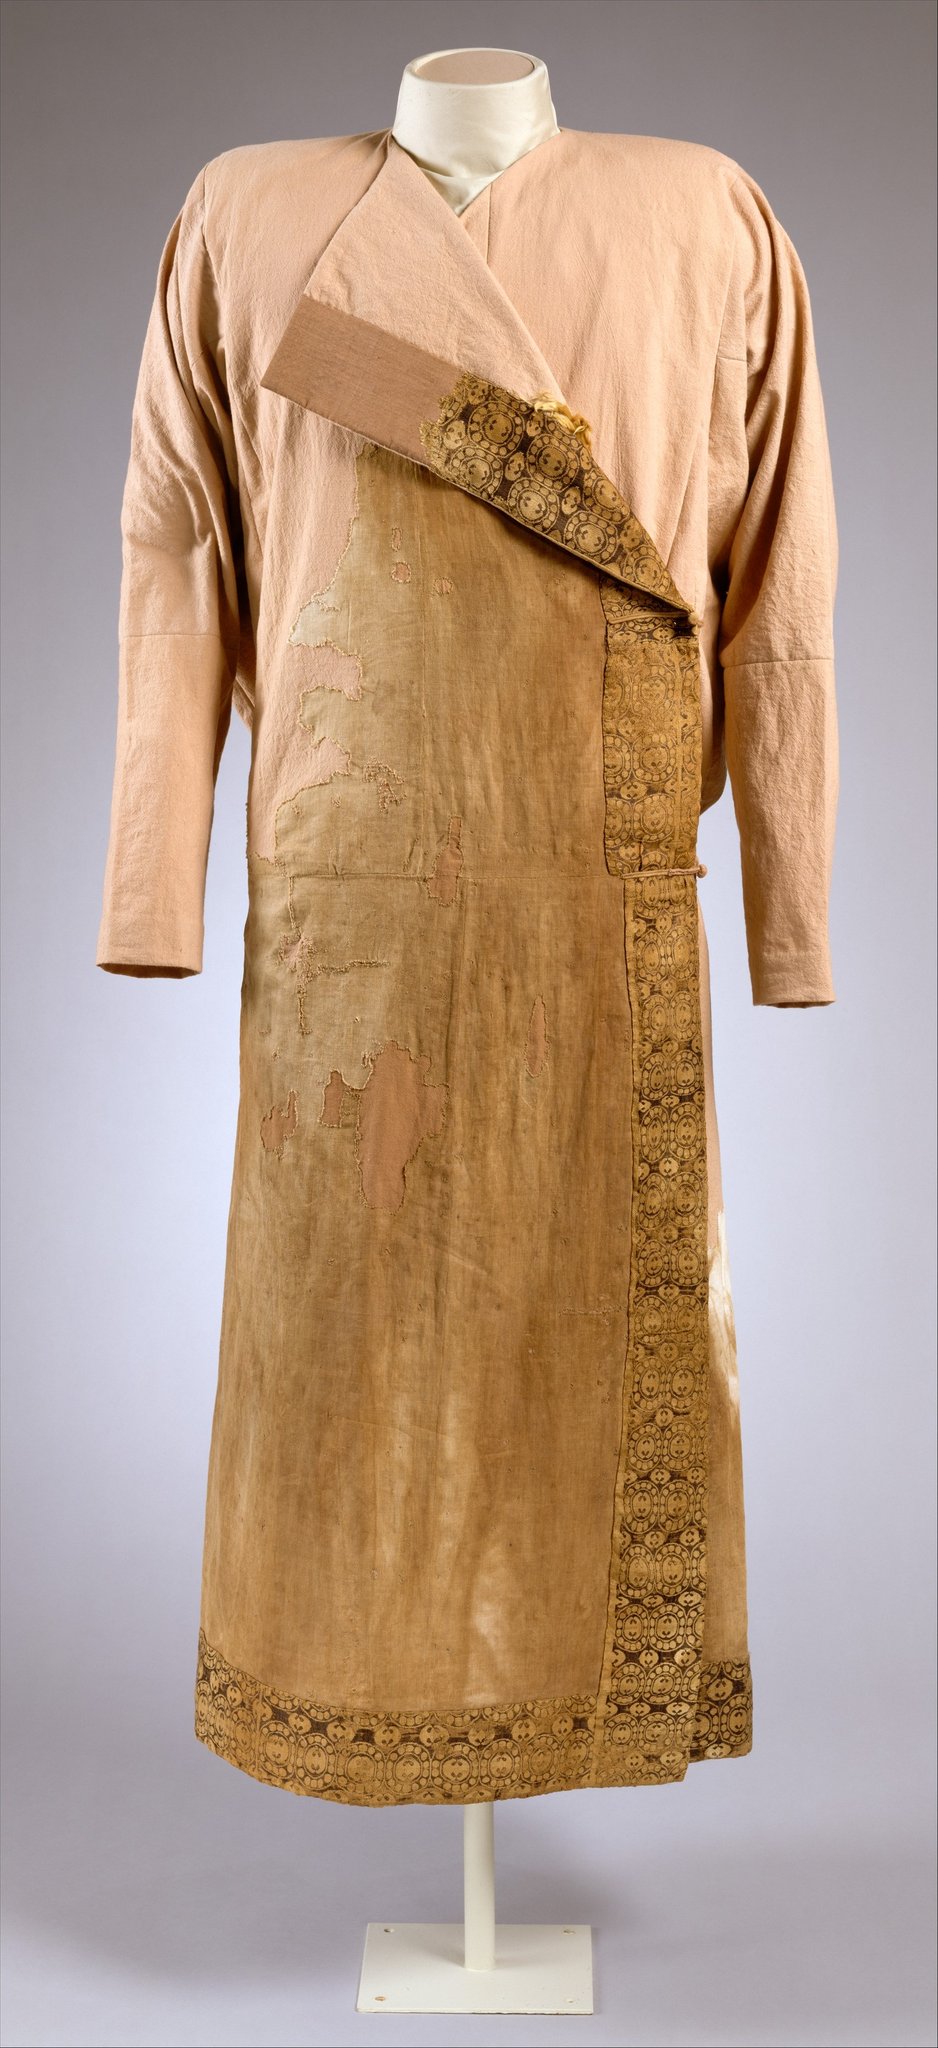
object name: textile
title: Kaftan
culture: alanic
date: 601-900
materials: fur, linen, silk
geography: caucasus